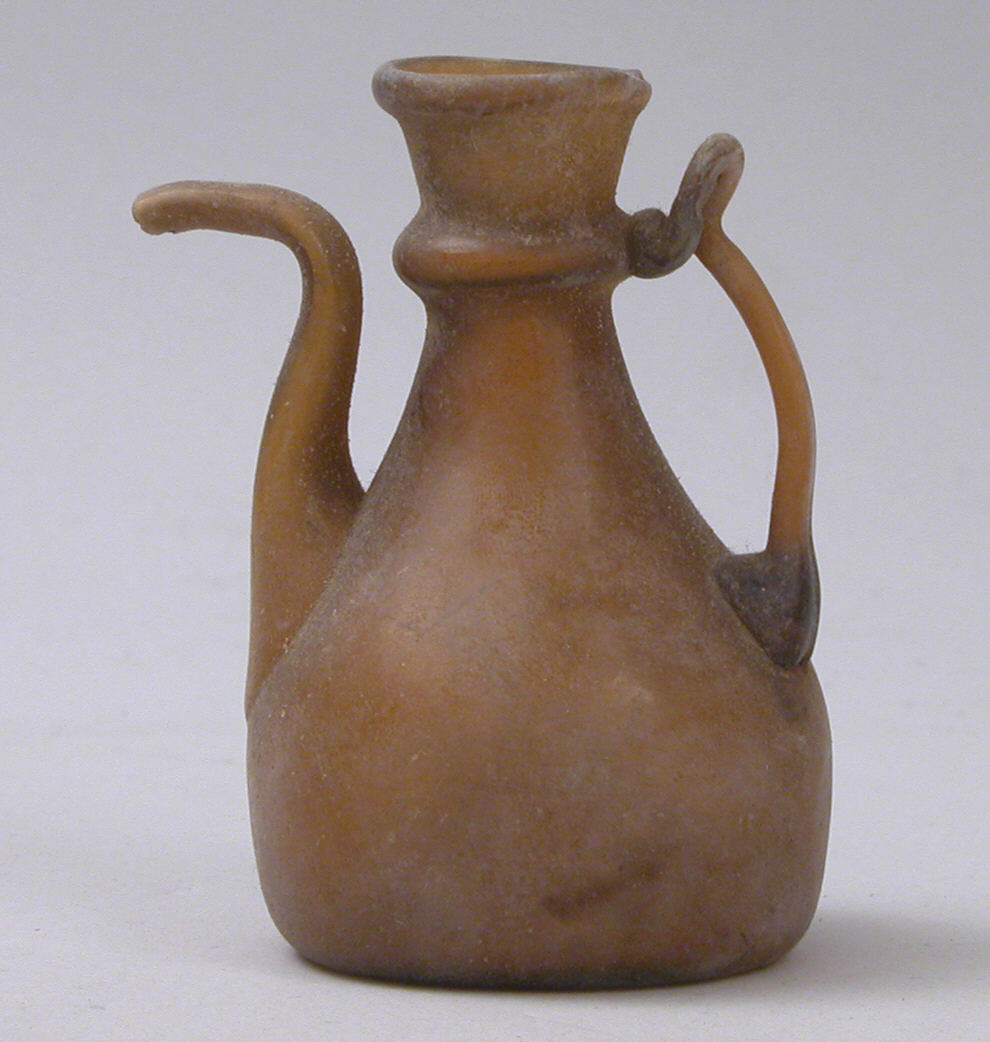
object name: ewer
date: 1801-1900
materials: glass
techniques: glassblowing, tooling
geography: palestine